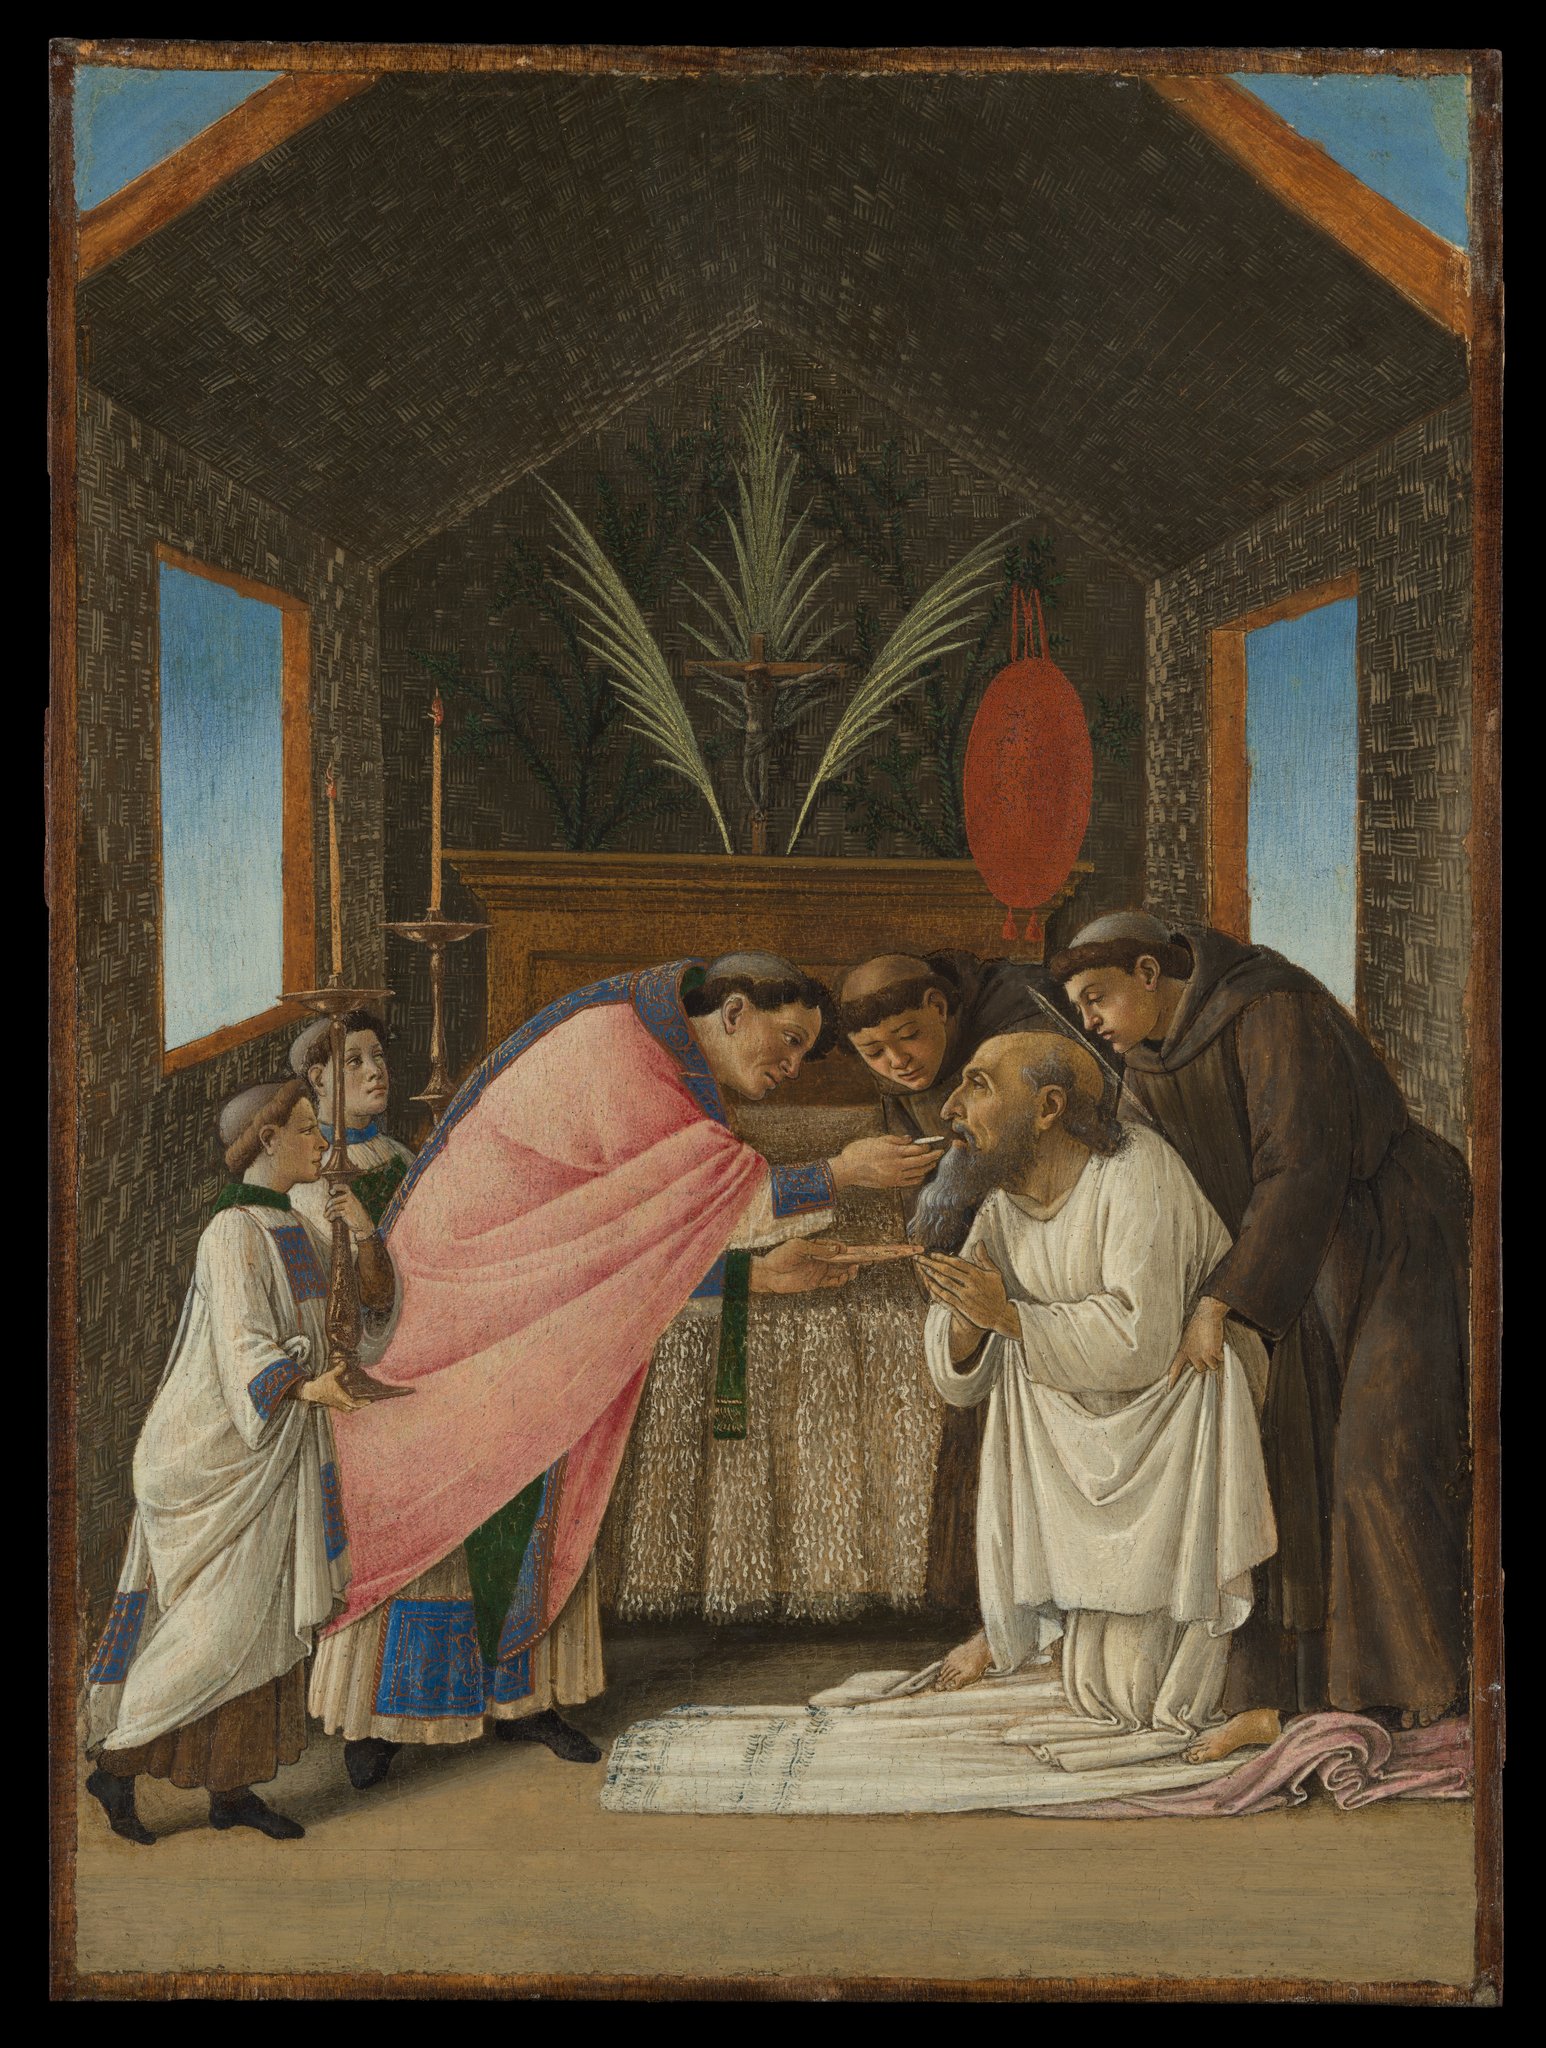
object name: painting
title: The Last Communion of Saint Jerome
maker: botticelli (alessandro di mariano filipepi)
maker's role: artist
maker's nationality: italian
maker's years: 1444-1510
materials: gold, paint, wood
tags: saint jerome,monks,crucifixion